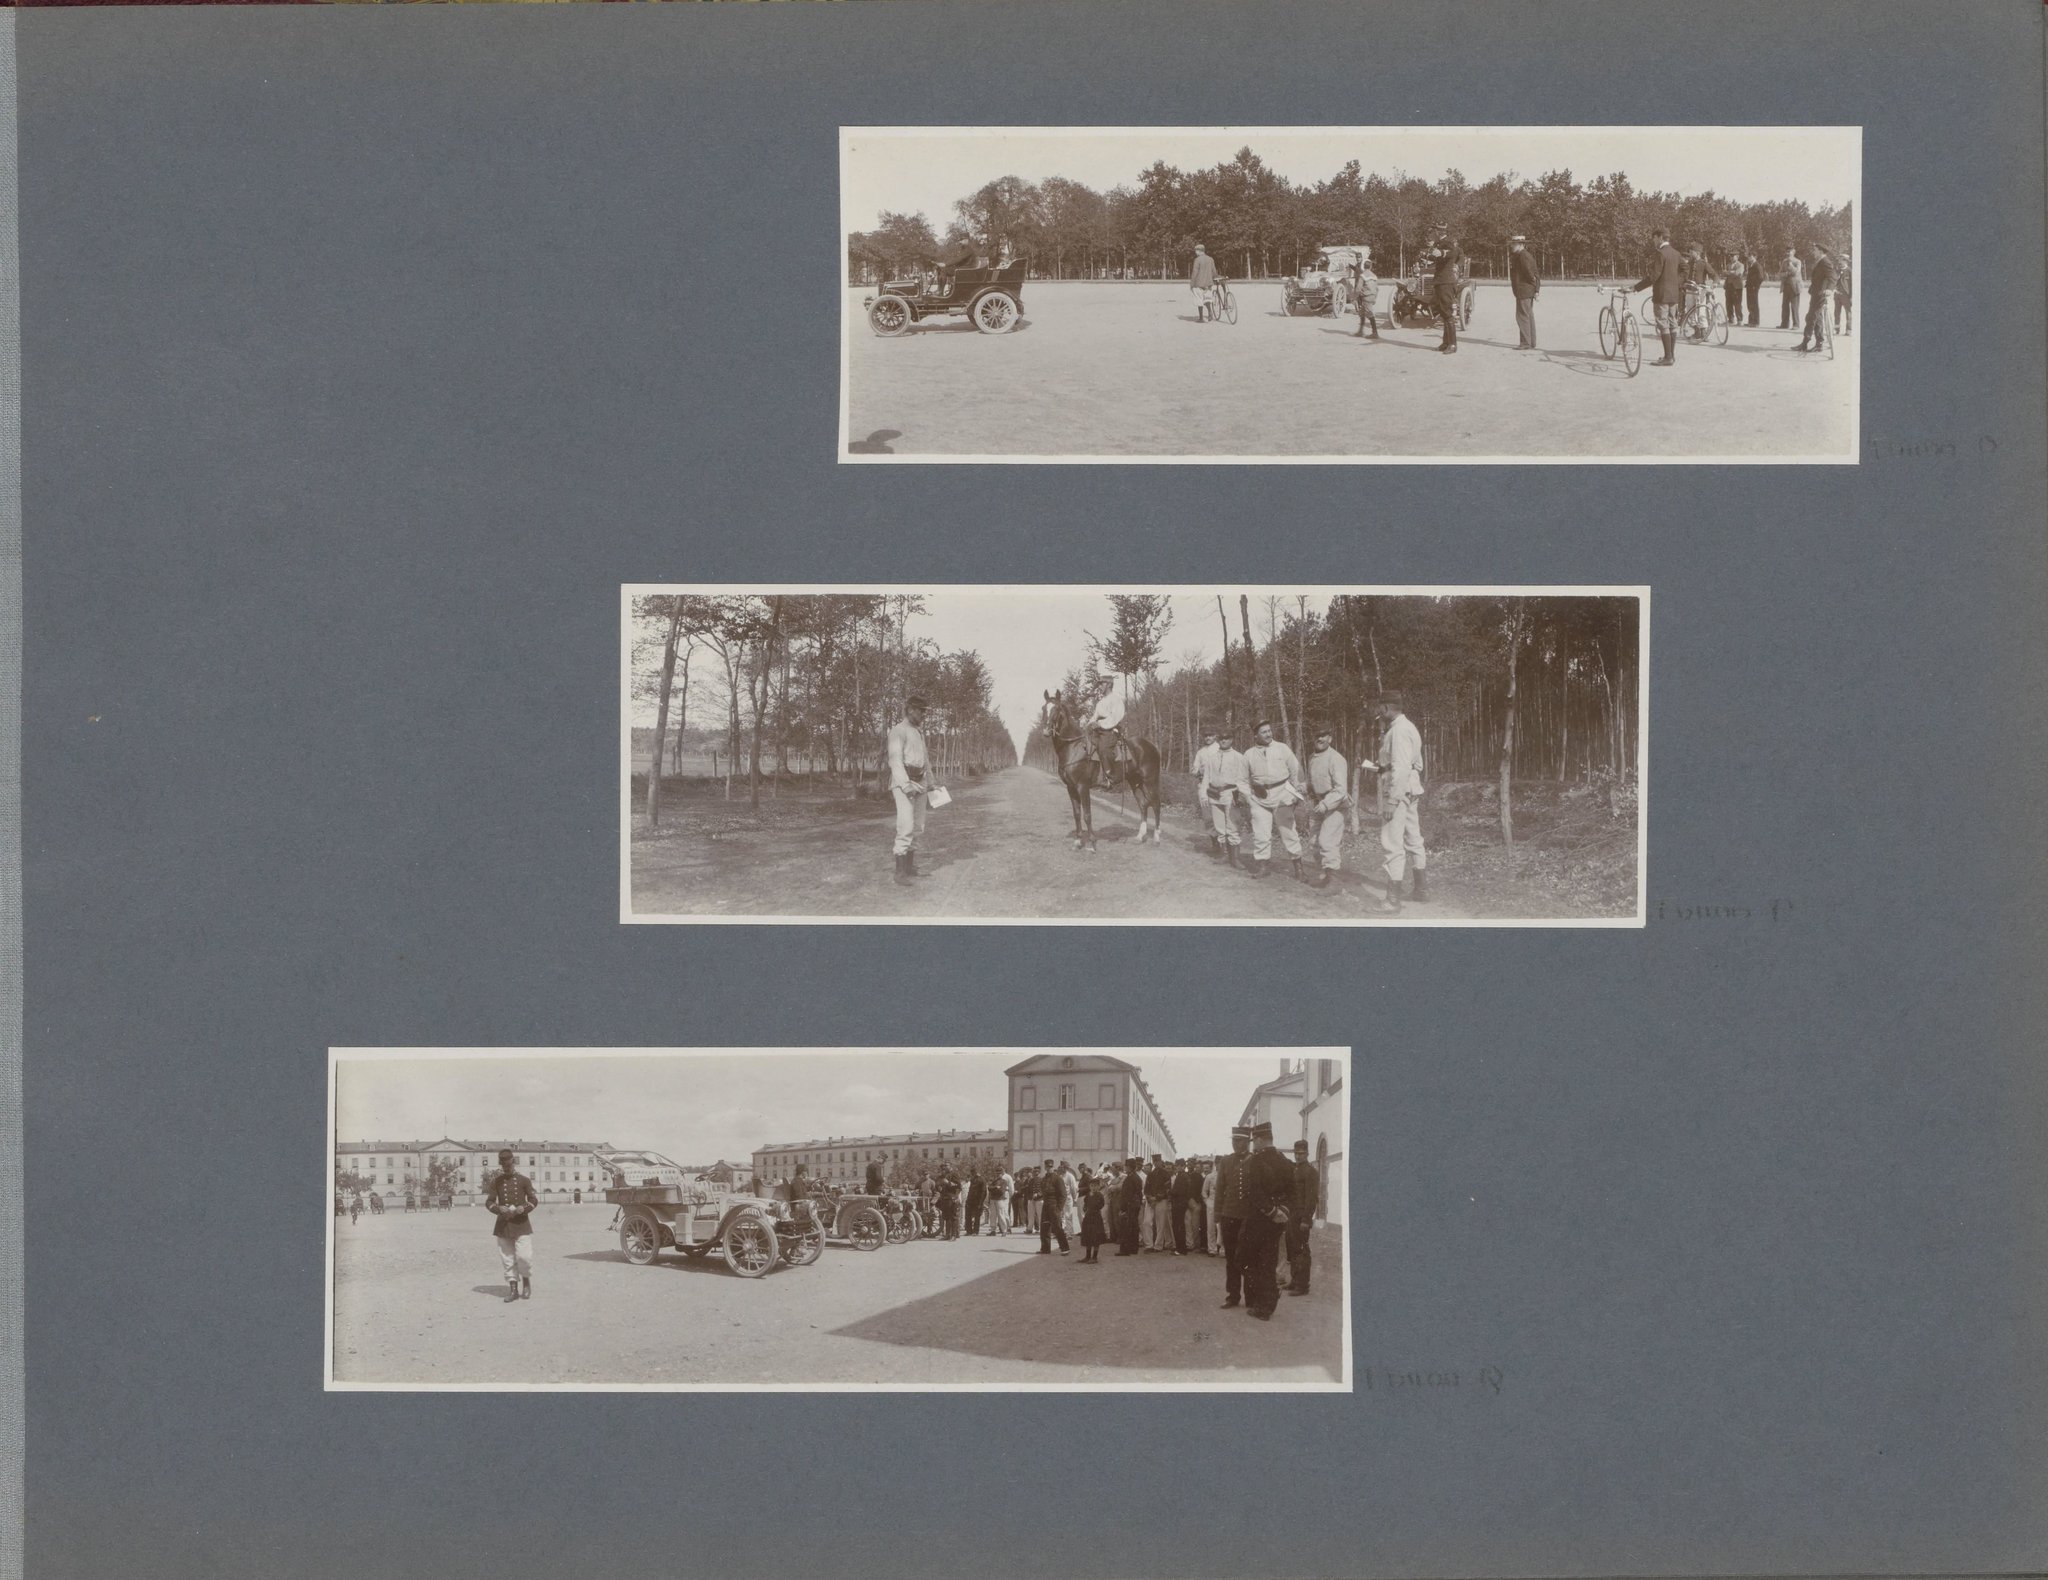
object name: photograph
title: Militairen en burgers bij auto's op een plein in Frankrijk, mogelijk bij een kazerne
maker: Anonymous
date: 1902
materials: paper, photographic support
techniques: daylight paper print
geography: france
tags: square, place, circus, etc., land forces, automobile, france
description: Onderdeel van Fotoalbum van een legeroefening in Zuidwest-Frankrijk in 1902.